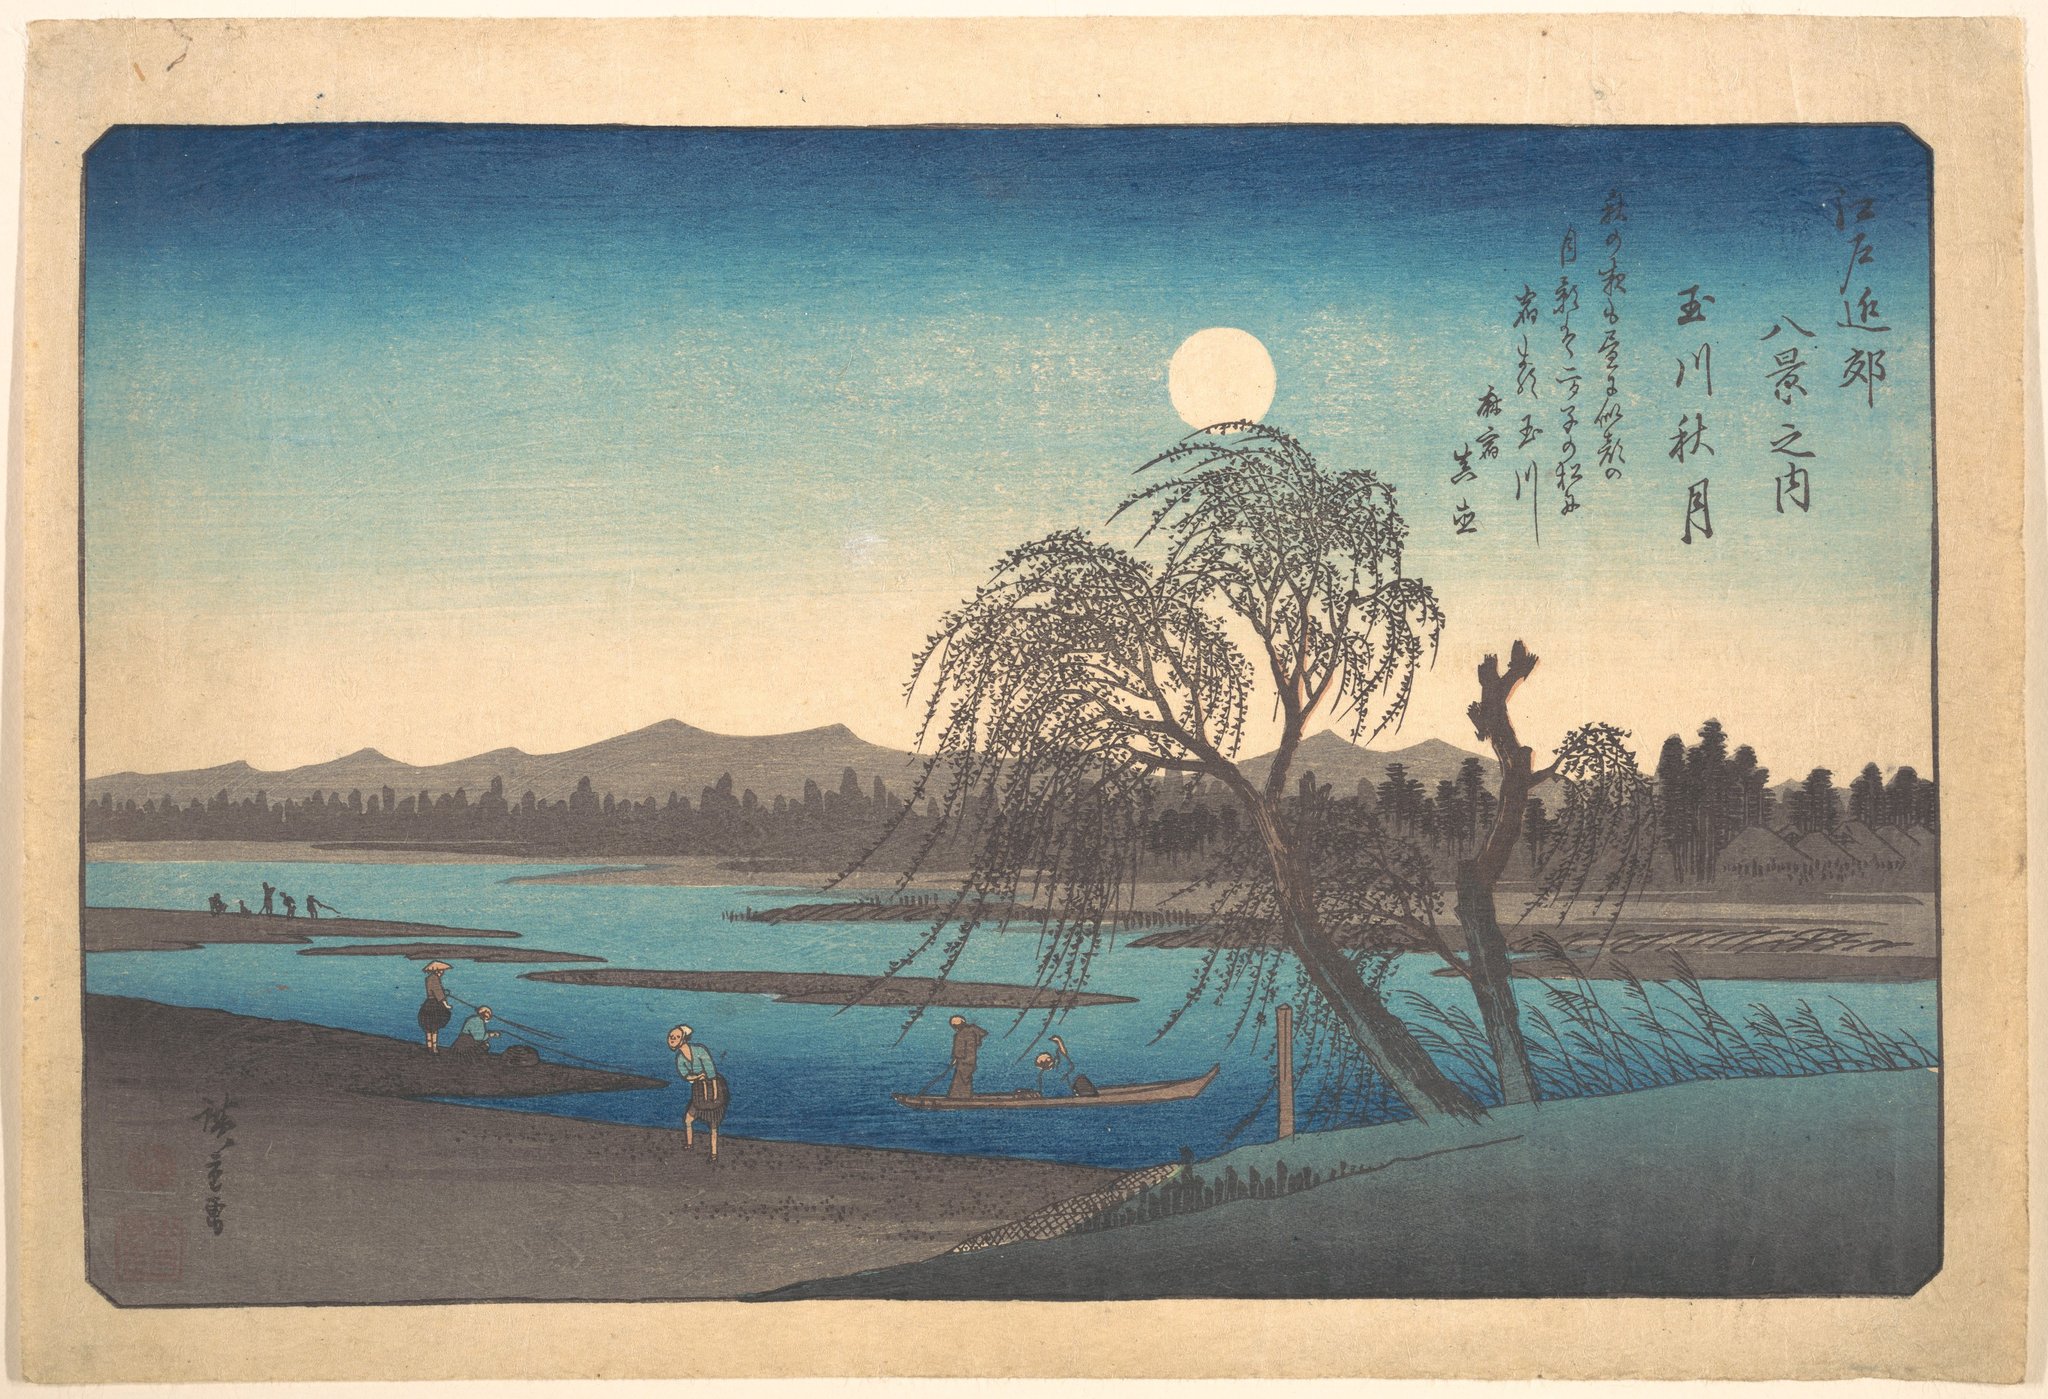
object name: print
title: Autumn Moon on the Tama River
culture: japanese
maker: utagawa hiroshige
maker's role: artist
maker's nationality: japanese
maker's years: 1797-1858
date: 1838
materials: ink, paper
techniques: woodblock print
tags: rivers,moon,landscapes,autumn